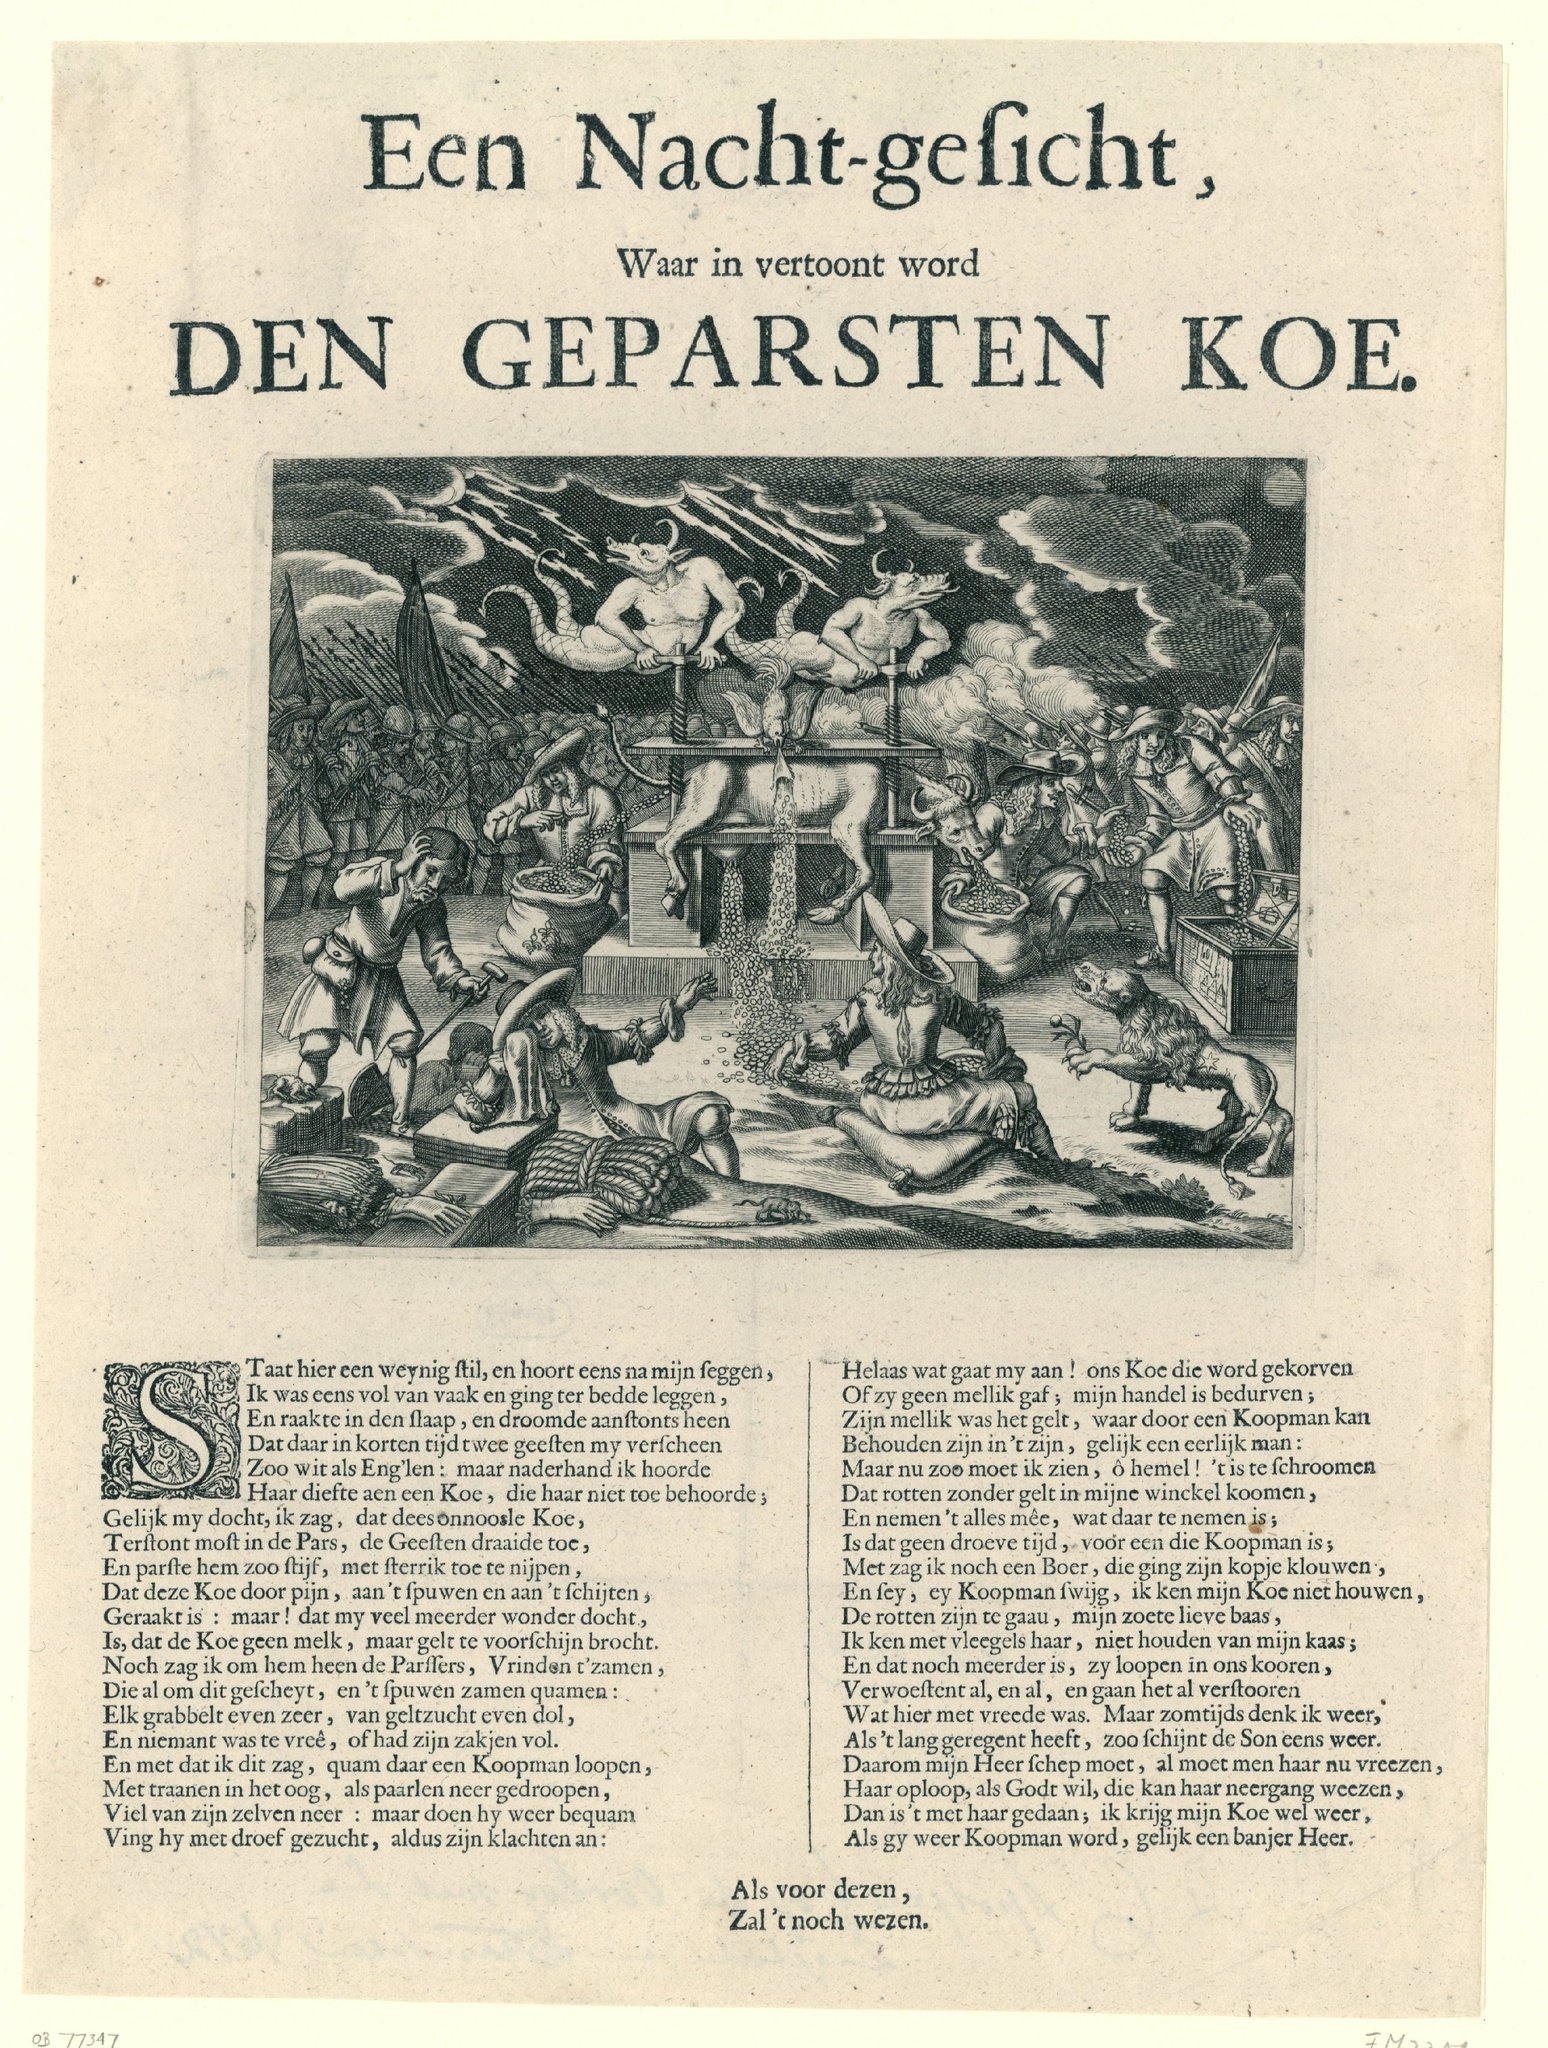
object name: print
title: Spotprent op de benarde positie van de Nederlanden aan het begin van het jaar 1672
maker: Anonymous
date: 1672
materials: paper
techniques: engraving, etching, letterpress printing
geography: northern netherlands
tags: cornelis de witt, the hague, politician, johan de witt, night, rampjaar (disaster year)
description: Spotprent op de benarde positie van de Nederlanden aan het begin van het jaar 1672. In een droombeeld ziet de schrijver van het onderschrift hoe geldstukken uit de Nederlandse Koe wordt geperst door twee duivels, de gebroeders De Witt. Het geld wordt door de Fransen opgevangen. Op de achtergrond vuren Franse soldaten in de lucht, terwijl de Nederlandse troepen moeten toezien zonder in te grijpen. Op de voorgrond staat de Nederlandse Leeuw met een oranjetak in zijn poot. Onder de voorstelling een beschrijving van het droombeeld over twee kolommen. Deze prent behoort bij FMH nrs. 2310 en 2311.